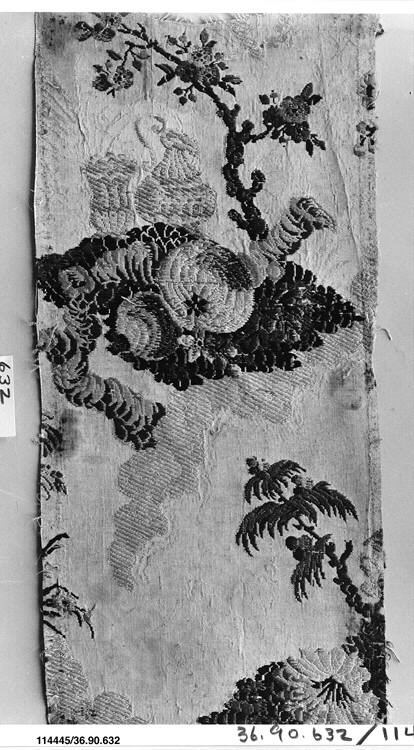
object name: piece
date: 1740-1750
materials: silk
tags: flowers,leaves